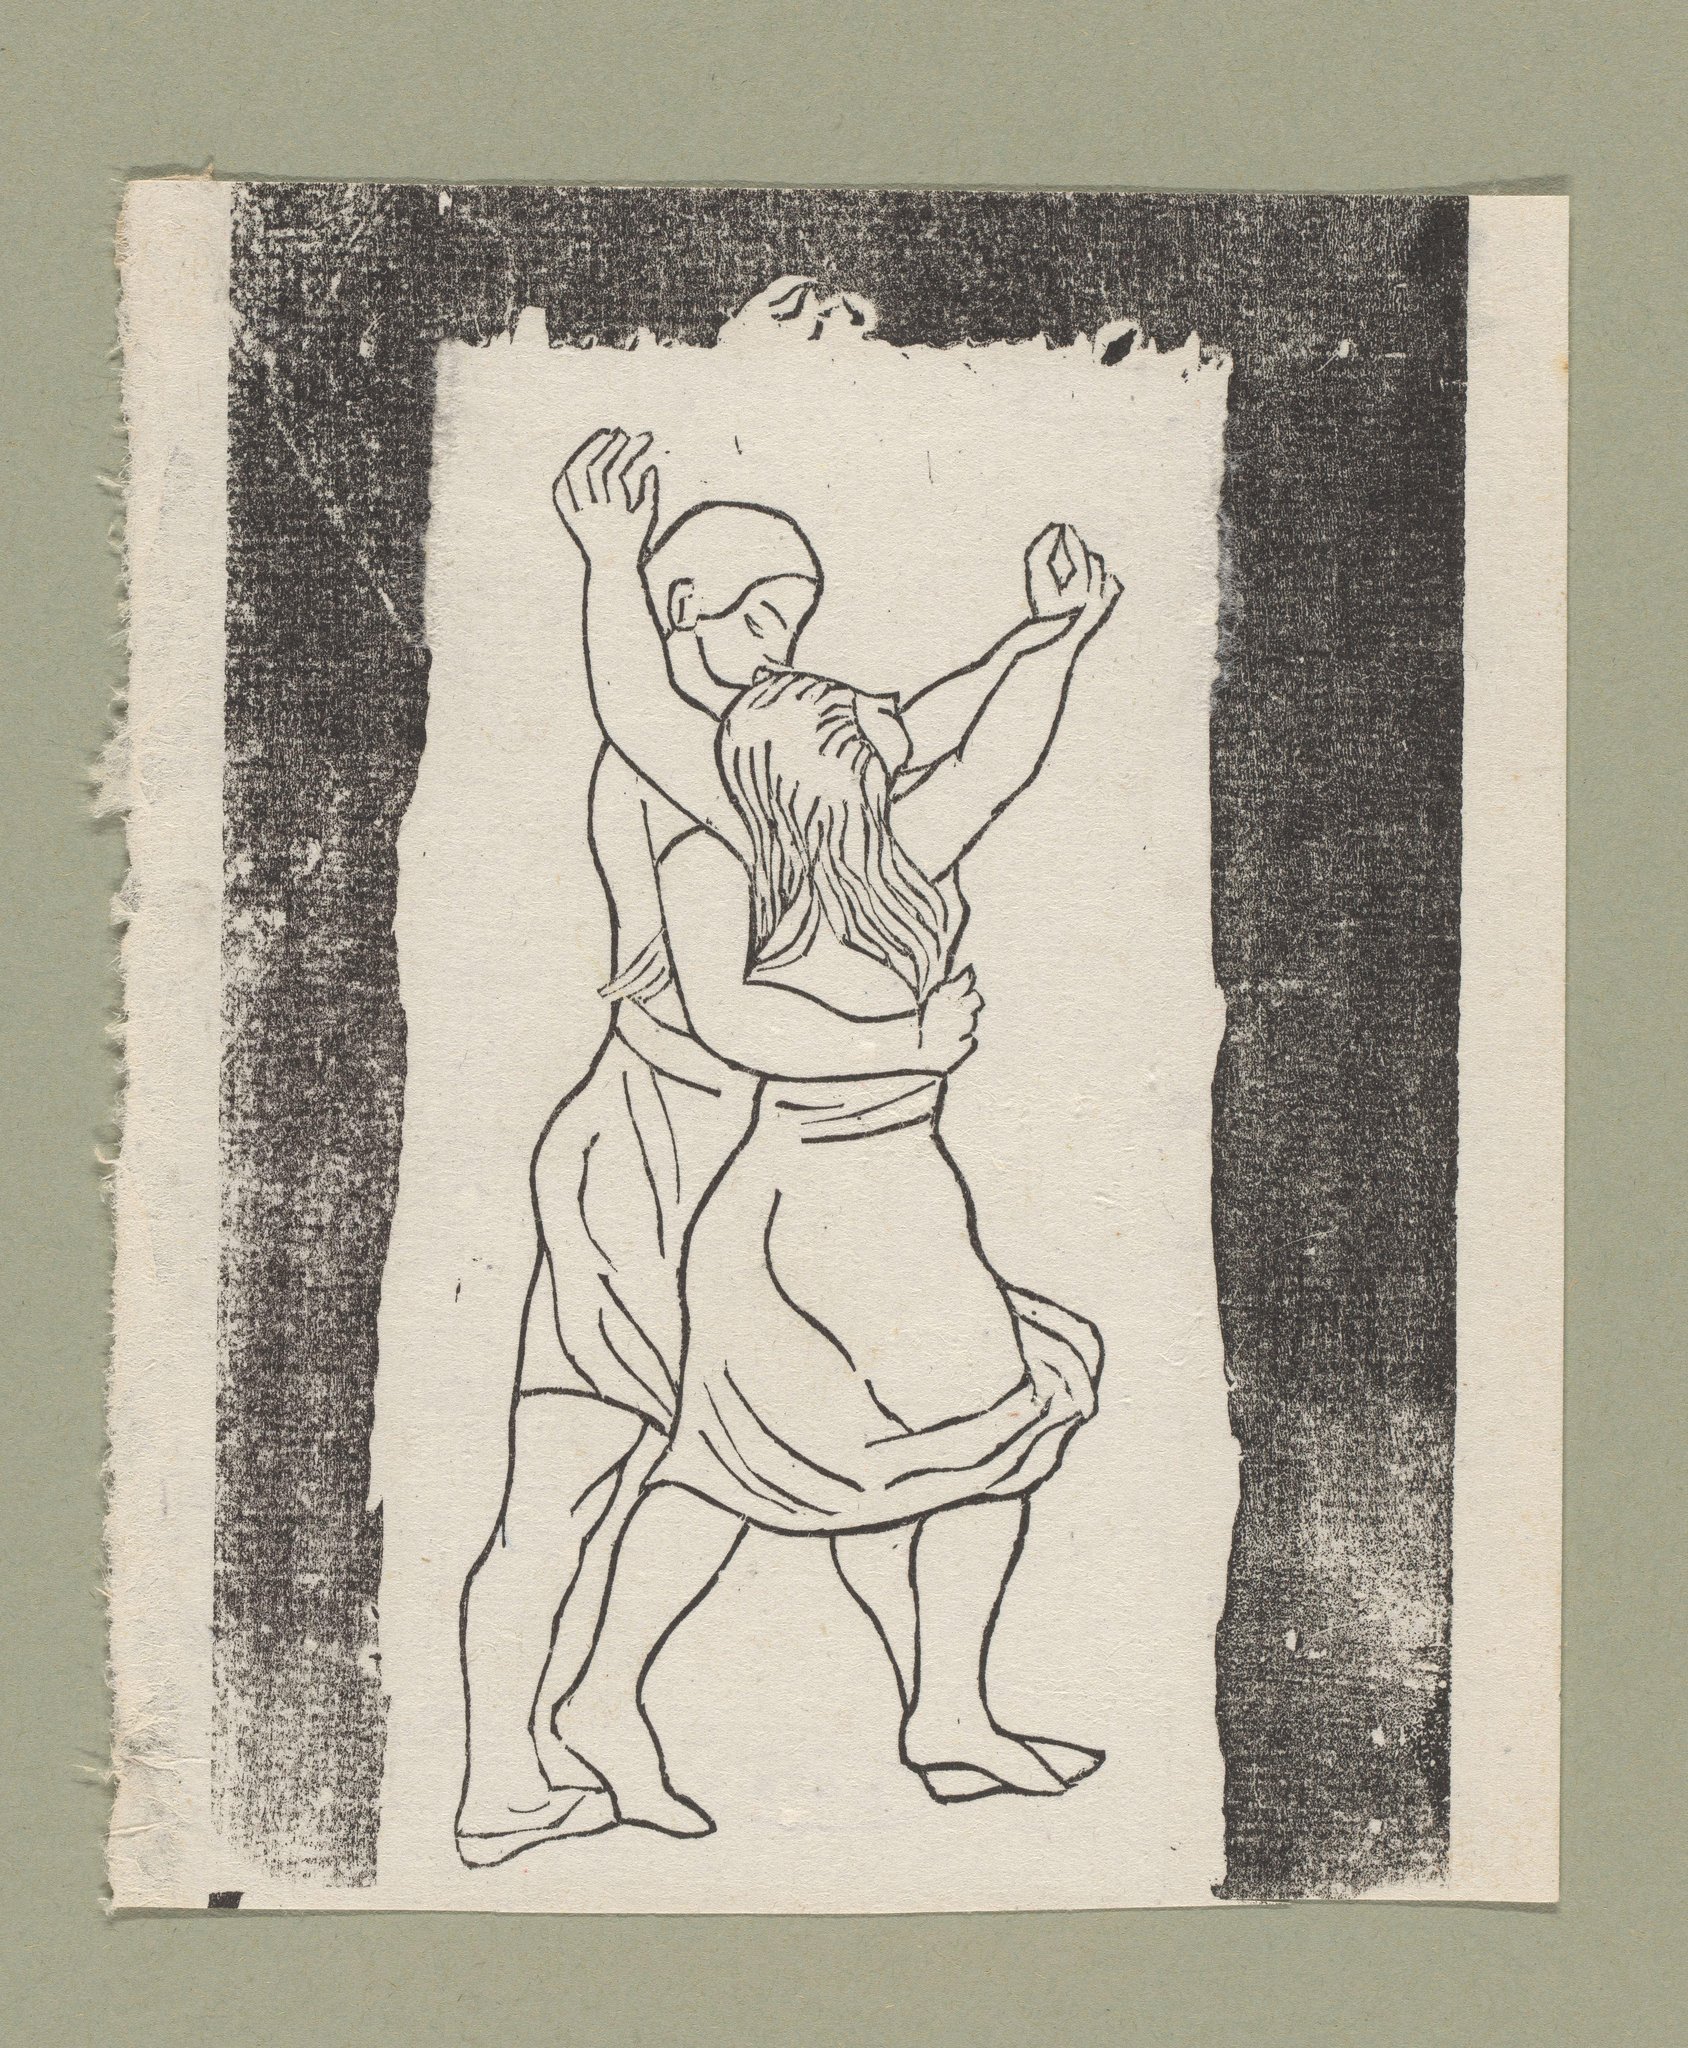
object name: book illustration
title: Chloë ontvoerd door de herder Lampis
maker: aristide maillol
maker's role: draughtsman, painter, print maker, sculptor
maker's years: 1861-1944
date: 1937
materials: paper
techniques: woodcut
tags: daphnis (in greek mythology a shepherd who invented pastoral poetry, chloe, man abducting woman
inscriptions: collector's mark: Lugt 2228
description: Latere staat van deze prent gebruikt in: Longus. Les Pastorales de Longus ou Daphnis & Chloé. Parijs: Frères Gonin, 1935, p. 202.